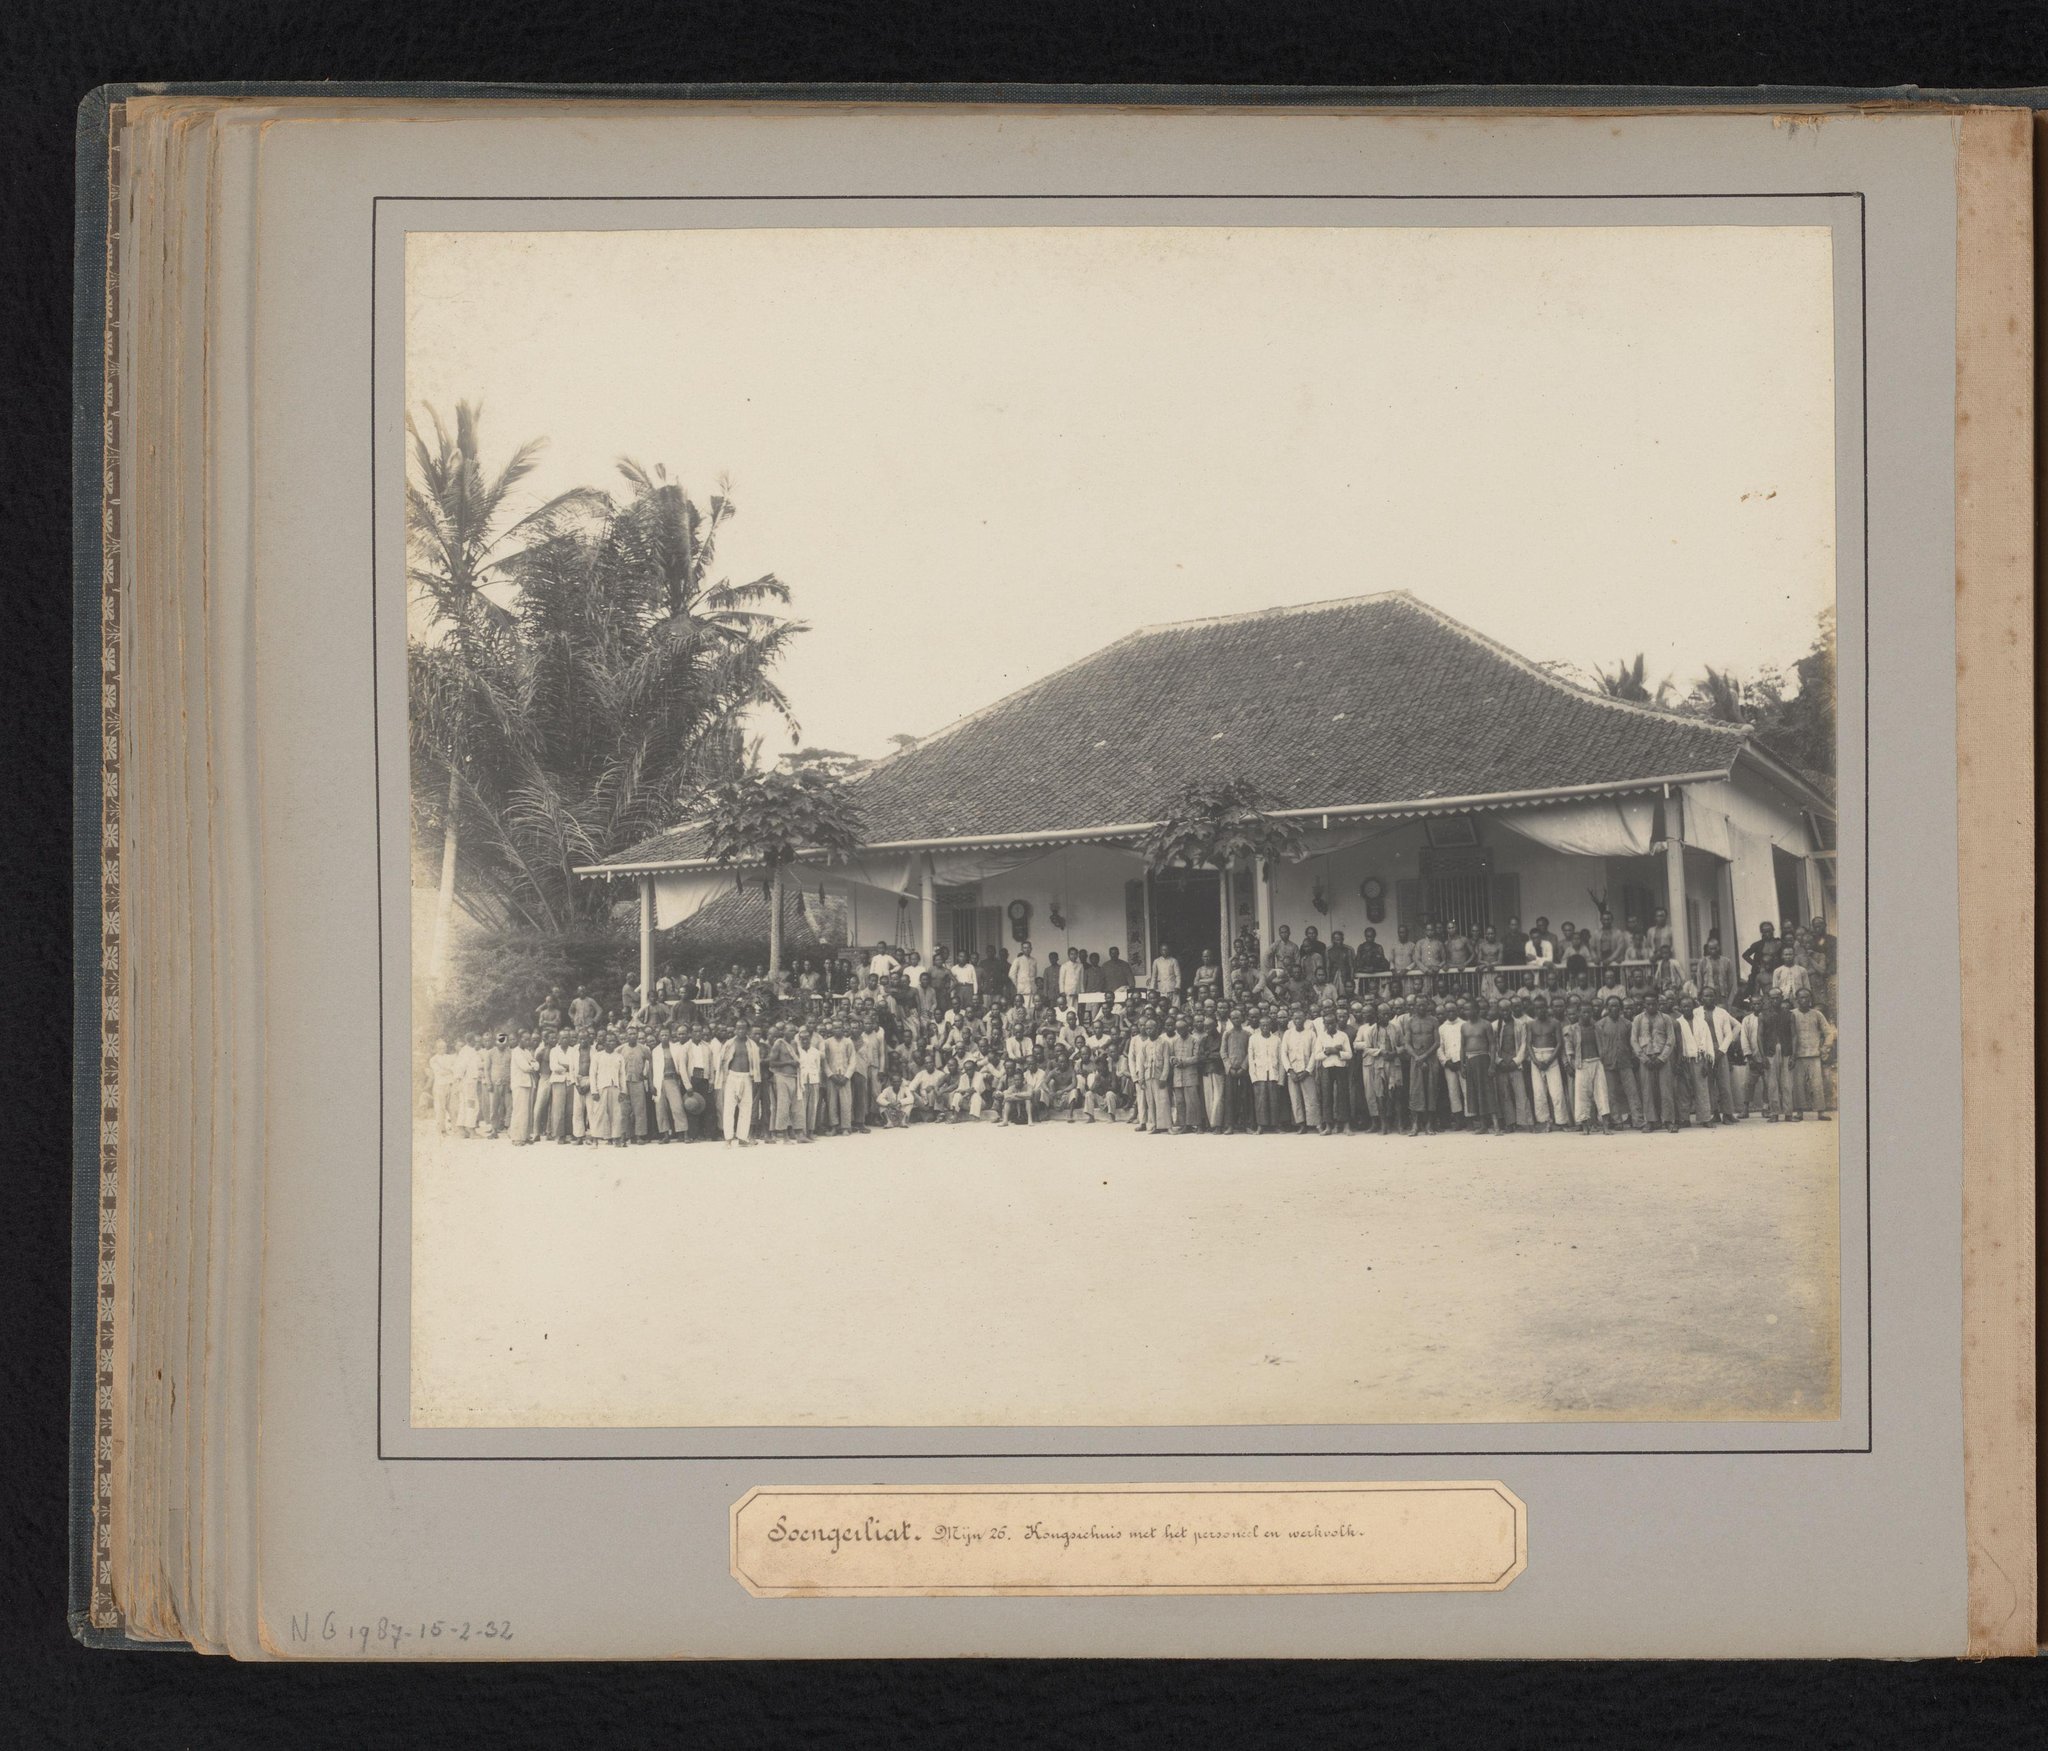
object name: photograph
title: Soengeiliat. Mijn 26. Kongihuis met het personeel en werkvolk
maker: Anonymous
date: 1907-1919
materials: cardboard, photographic support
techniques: gelatin silver print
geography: bangka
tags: robert julius boers, colonial system, miner, minerals and metals: tin, mine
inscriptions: label: ‘Soengeiliat. Mijn 26. Kongihuis met het personeel en werkvolk’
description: Kongsihuis, een verenigingshuis voor Chinese mijnwerkers van de Banka-tinwinning te Soengeiliat. Onderdeel van het fotoalbum over de Banka-tinwinning, ca. 1907-1919.